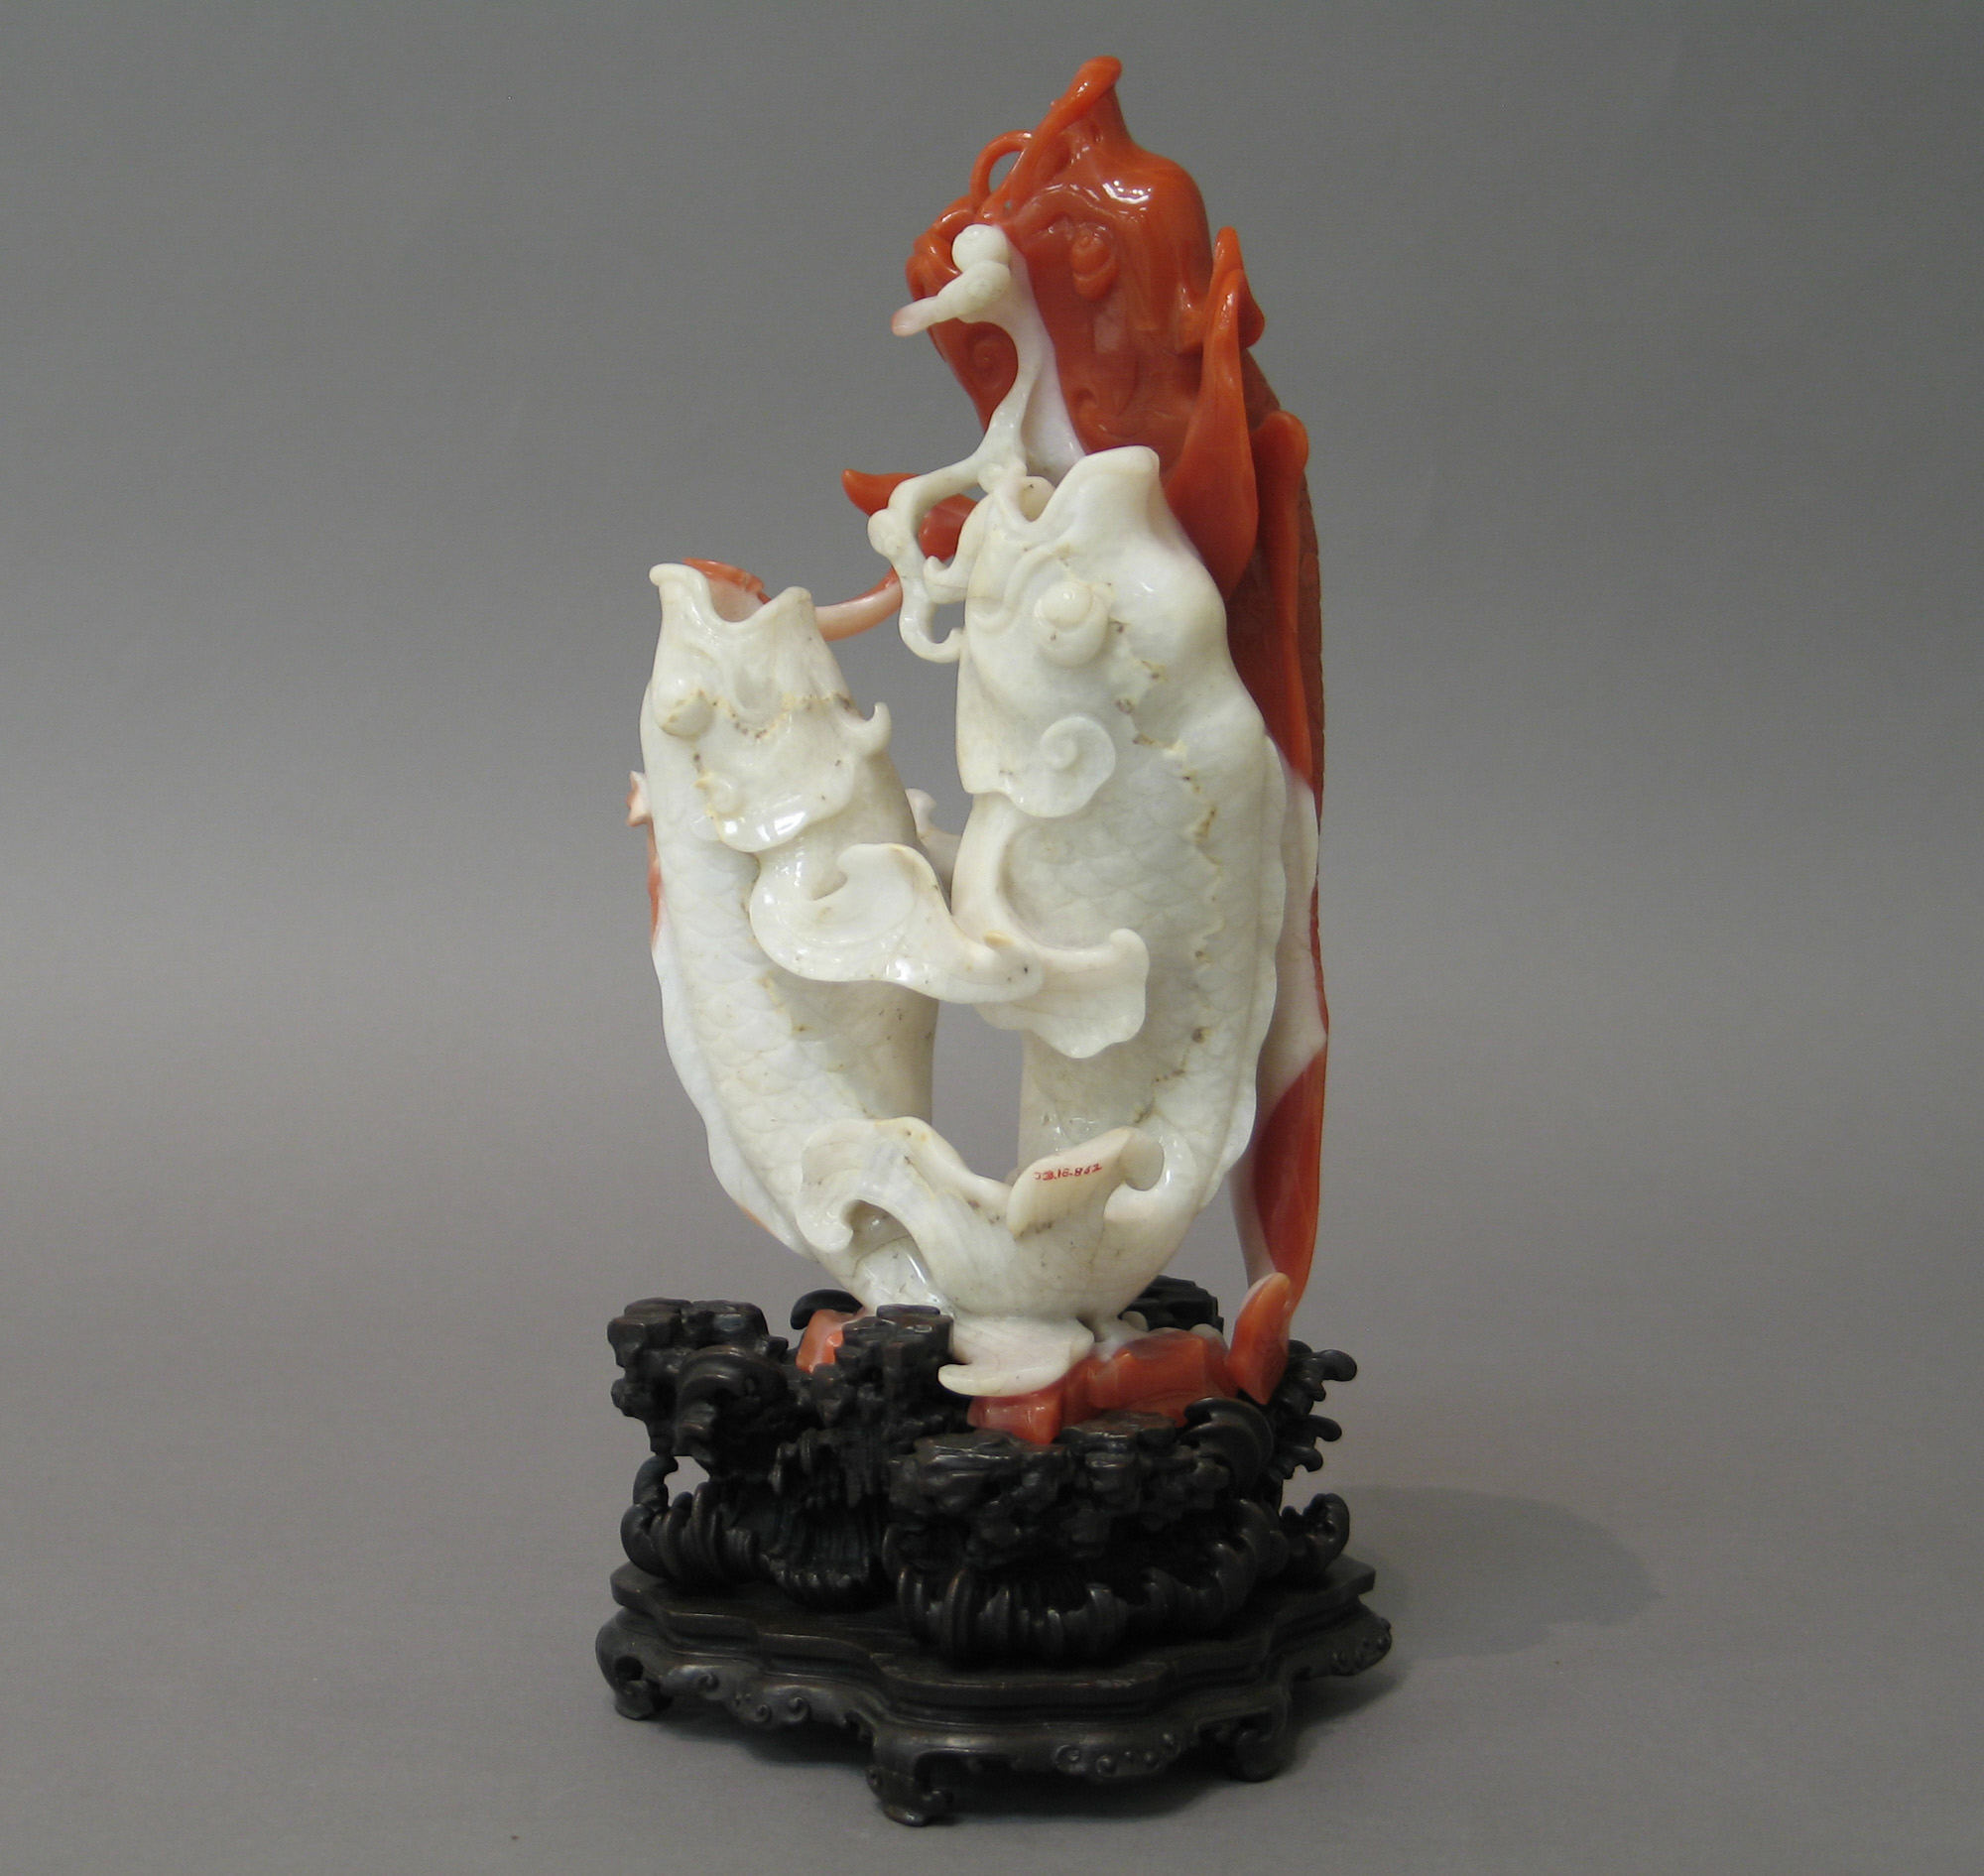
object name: flower receptacle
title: Three fish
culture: chinese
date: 1701-1800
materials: stone, gemstone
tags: fish